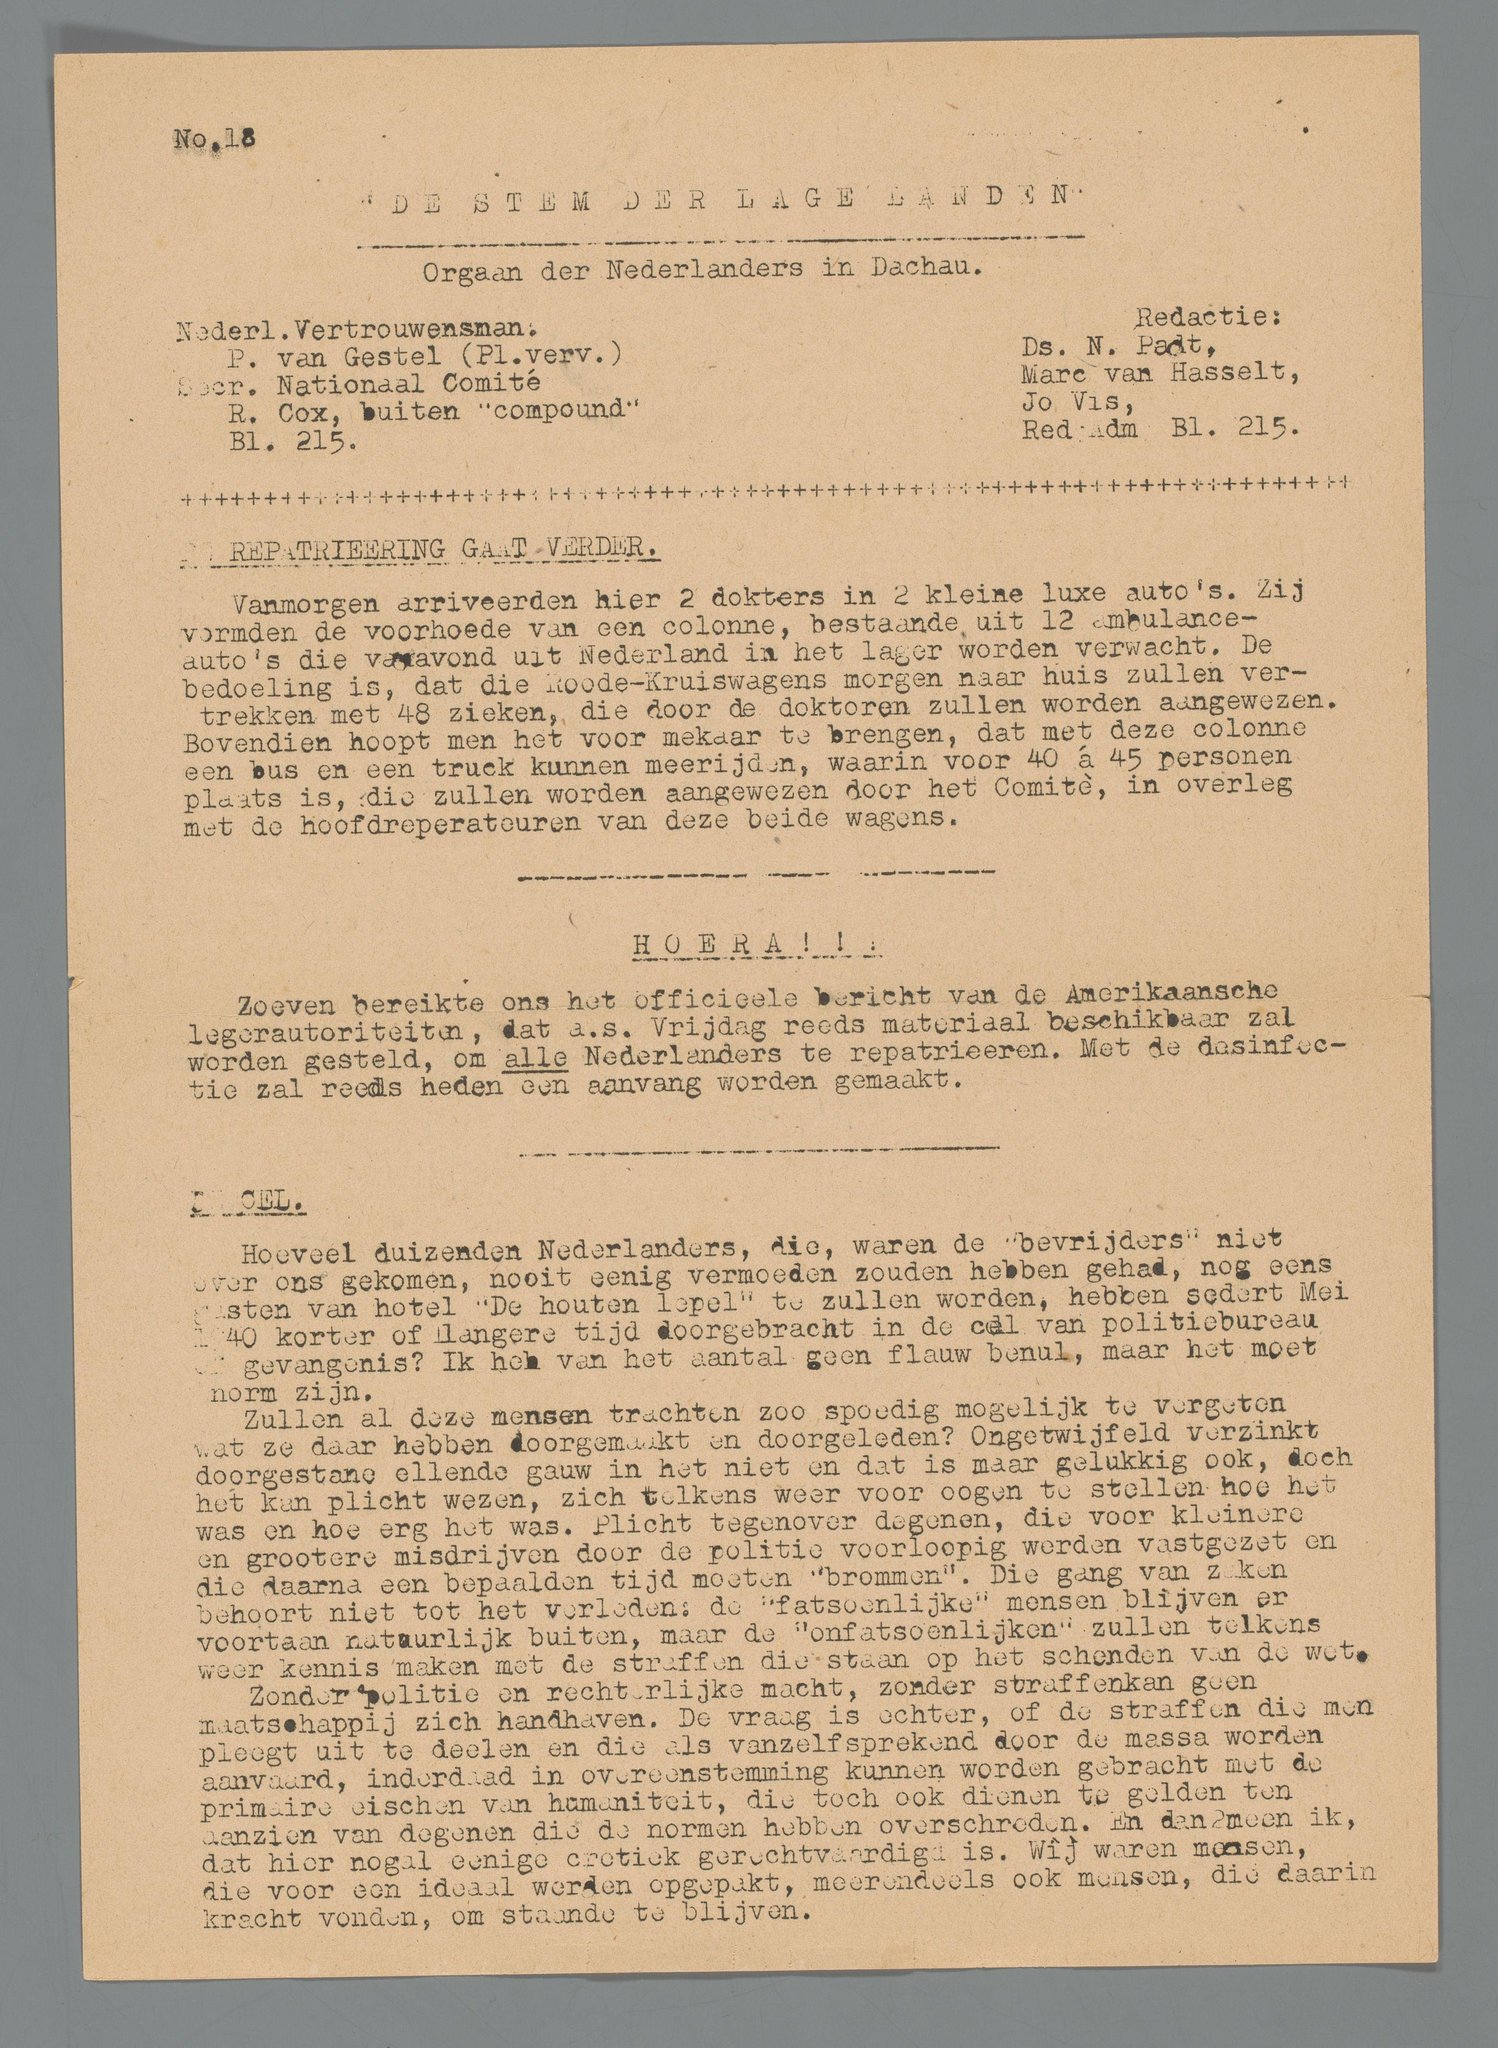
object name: pamphlet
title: De stem der lage landen, nr. 18, 22 mei 1945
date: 1945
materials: paper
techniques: mimeography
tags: etienne françois marie bouter, dachau, tweede wereldoorlog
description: Gestencilde krant 'De stem der lage landen / Orgaan der Nederlanders in Dachau', aflevering nr. 18, 22 mei 1945. Een blad bedrukt op beide zijden. Verschenen onder redactie van Marc van Hasselt, Jo Vis en ds. N. Padt.